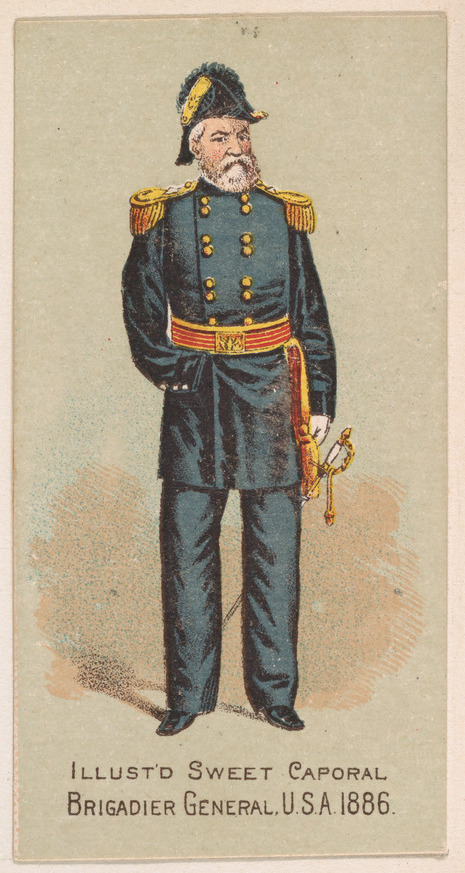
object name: print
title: Brigadier General, United States Army, 1886, from the Military Series (N224) issued by Kinney Tobacco Company to promote Sweet Caporal Cigarettes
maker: kinney brothers tobacco company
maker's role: publisher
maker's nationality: american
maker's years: 1869-2011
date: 1888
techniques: color lithograph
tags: military,men,generals